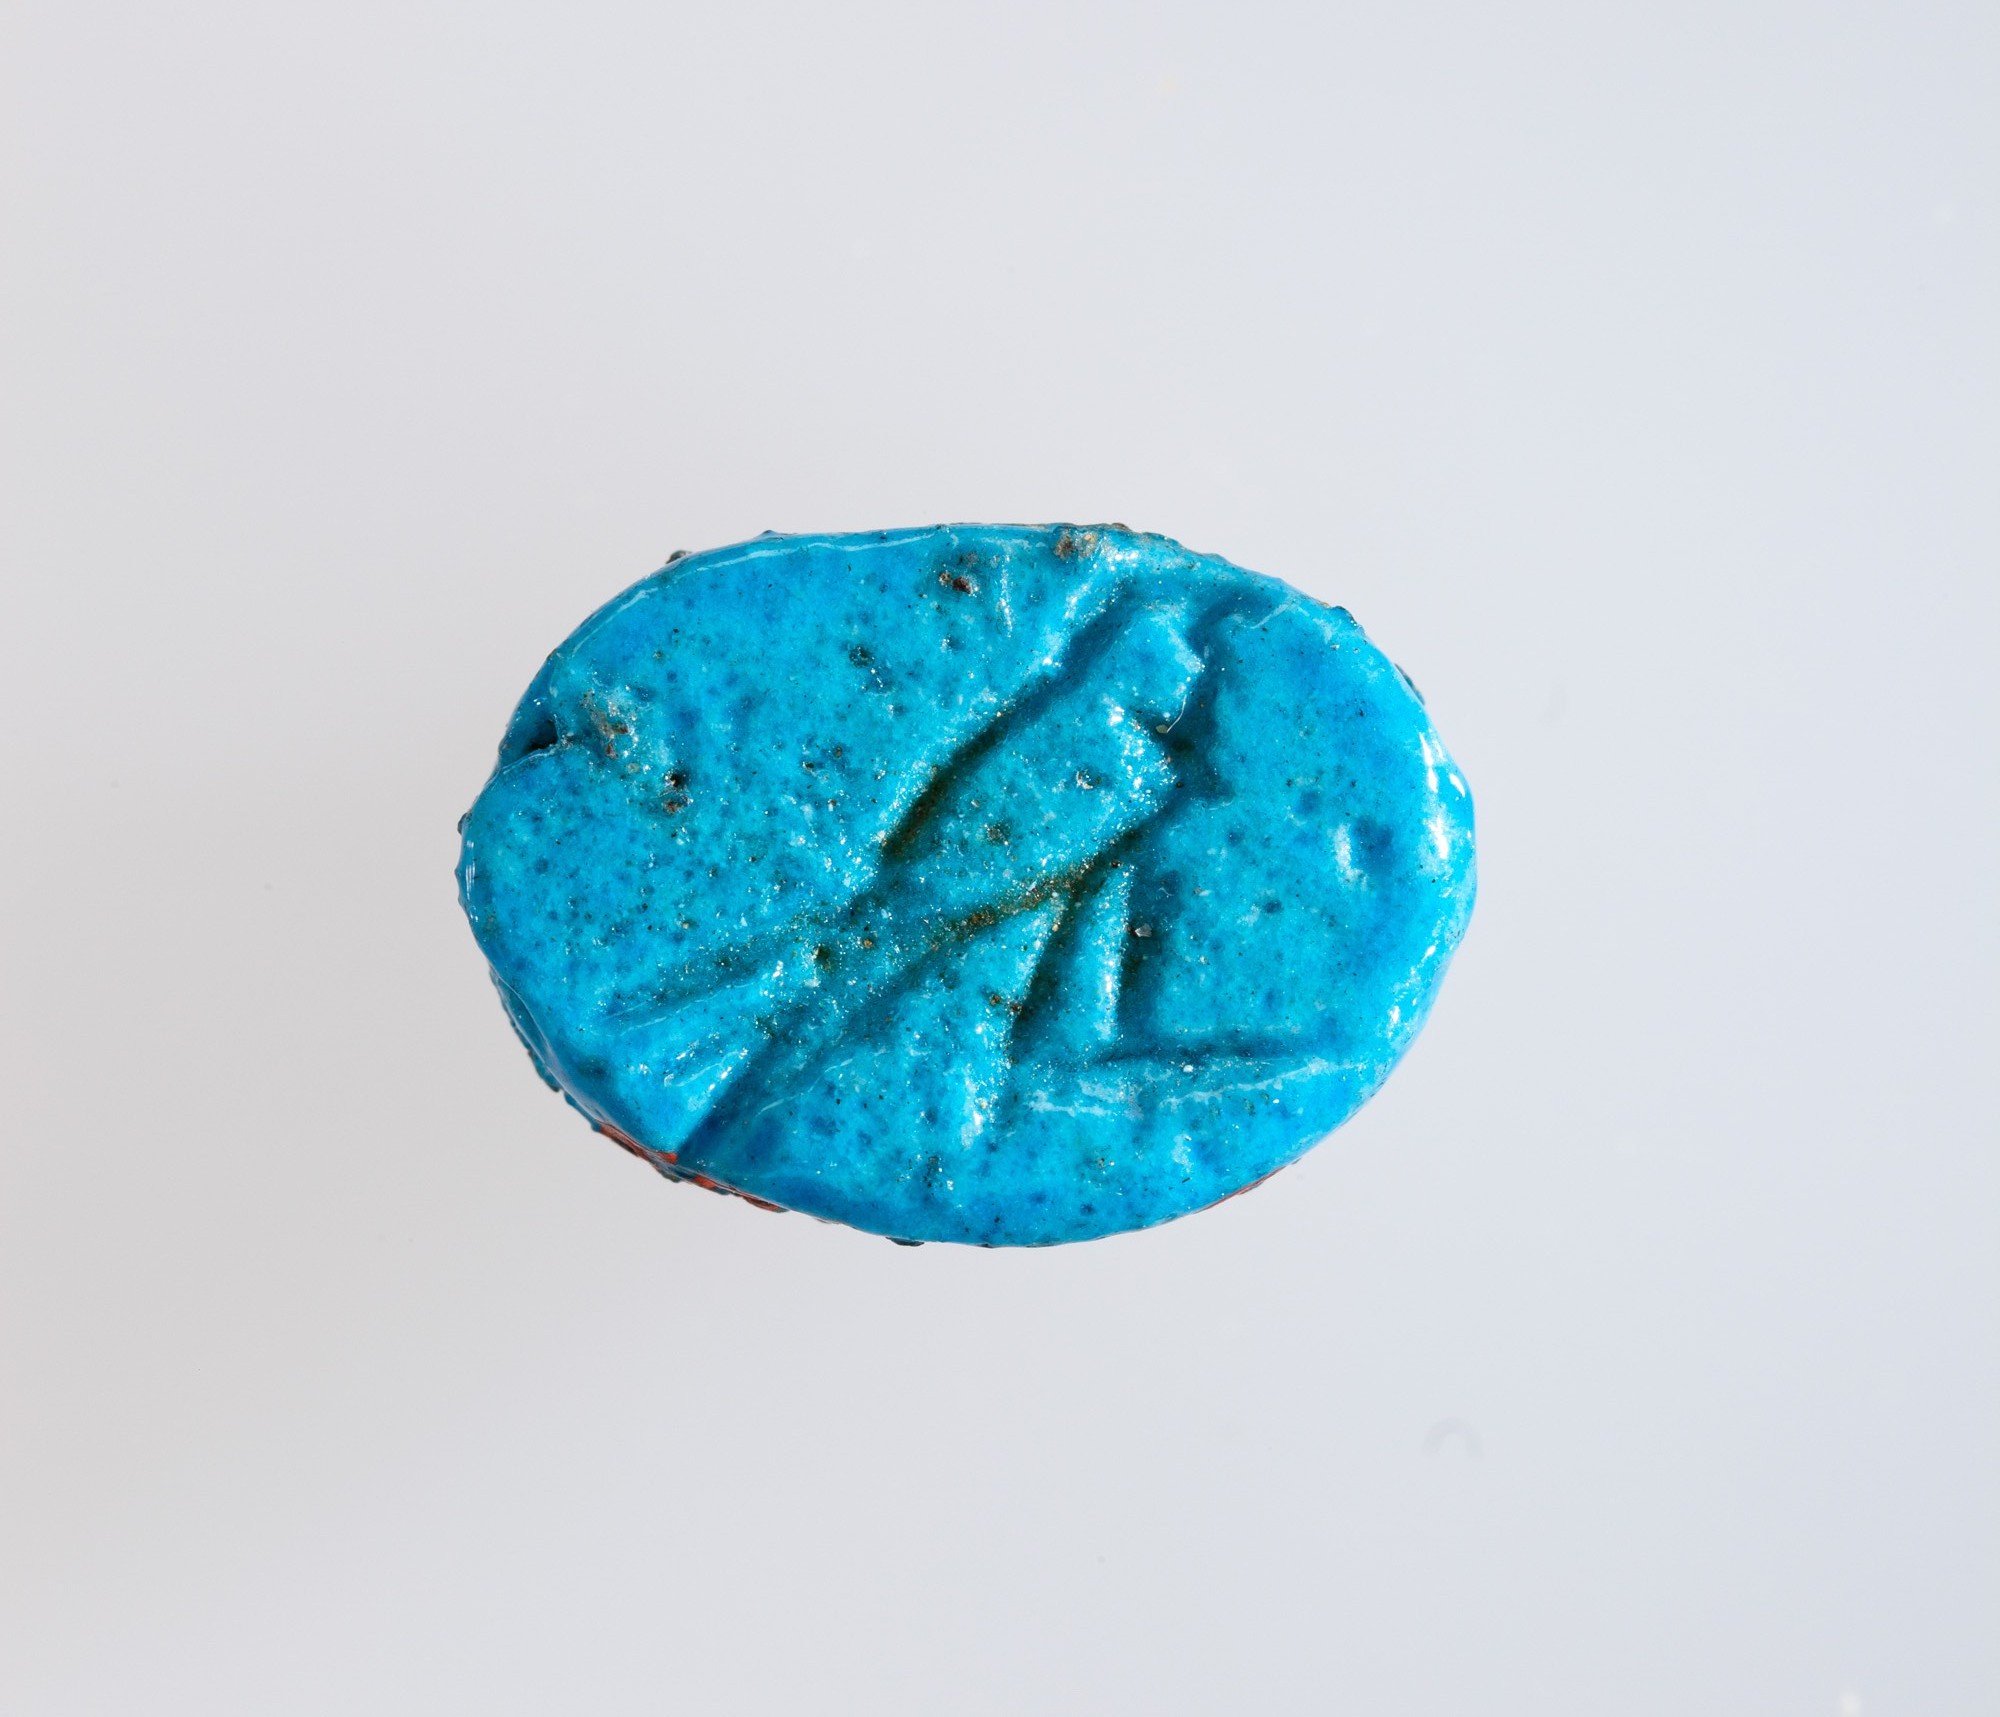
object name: scarab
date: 1479-1458 BCE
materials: faience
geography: egypt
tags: scarabs